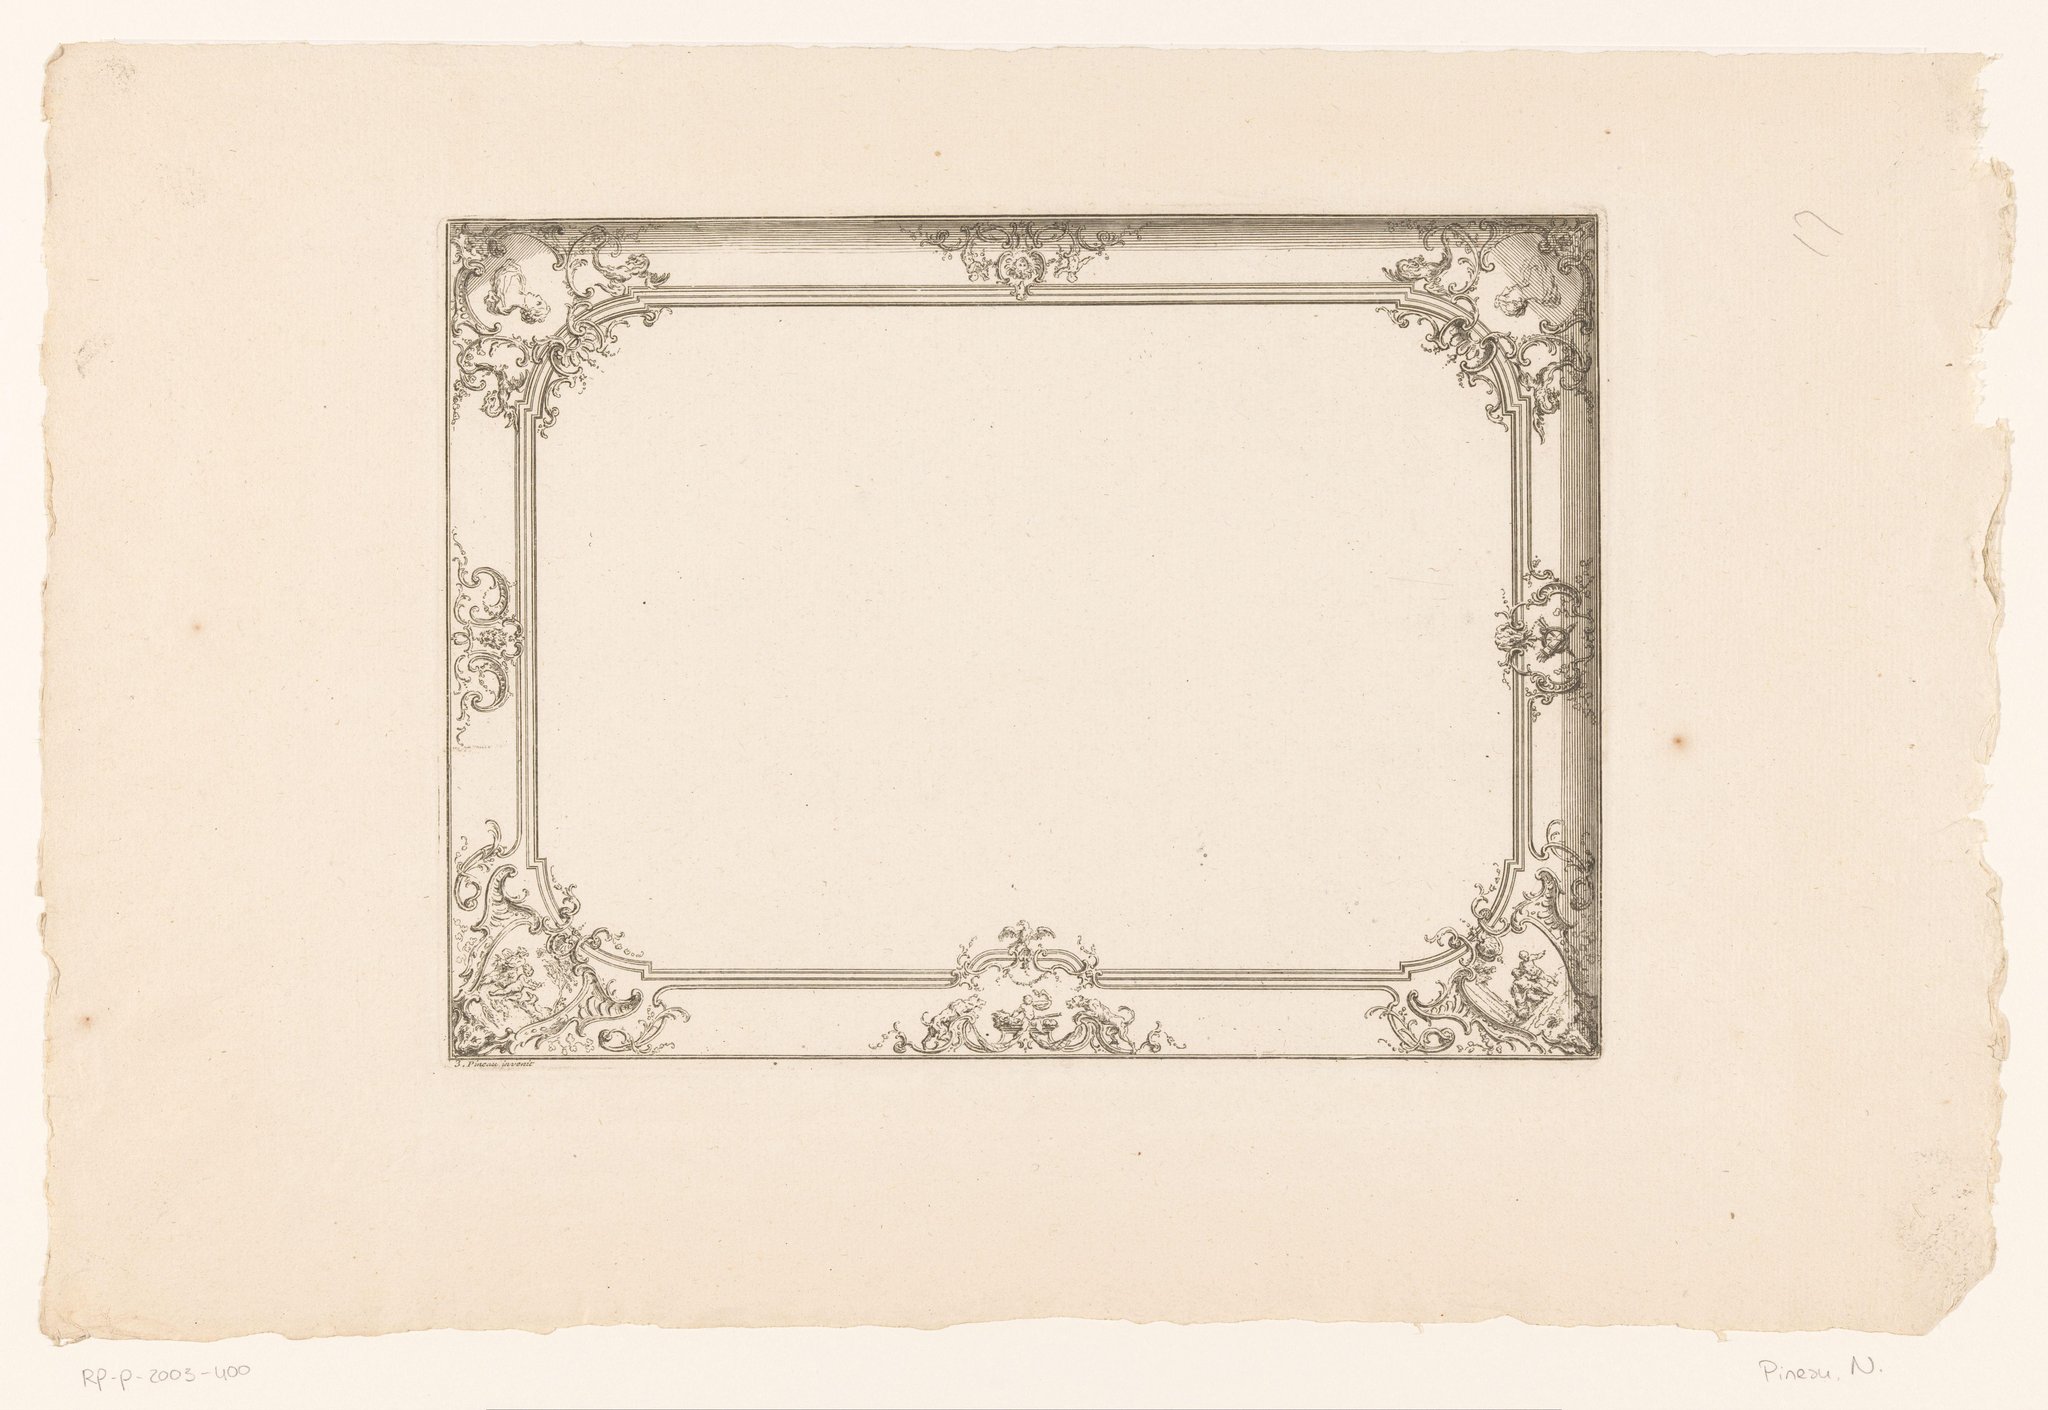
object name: ornament print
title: Nouveaux desseins de Plafonds inventés par Pineau et qui peuvent s'executer en sculture ou en peinture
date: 1725-1735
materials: paper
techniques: etching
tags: (decorated) ceiling, cupids: 'amores', 'amoretti', 'putti', chest, bust - aa - female human figure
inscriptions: collector's mark: Lugt 2760, collector's mark: Lugt 2228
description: Ontwerp voor een rechthoekig plafond met in de hoeken cartouches met vrouwenbustes en spelende putti.